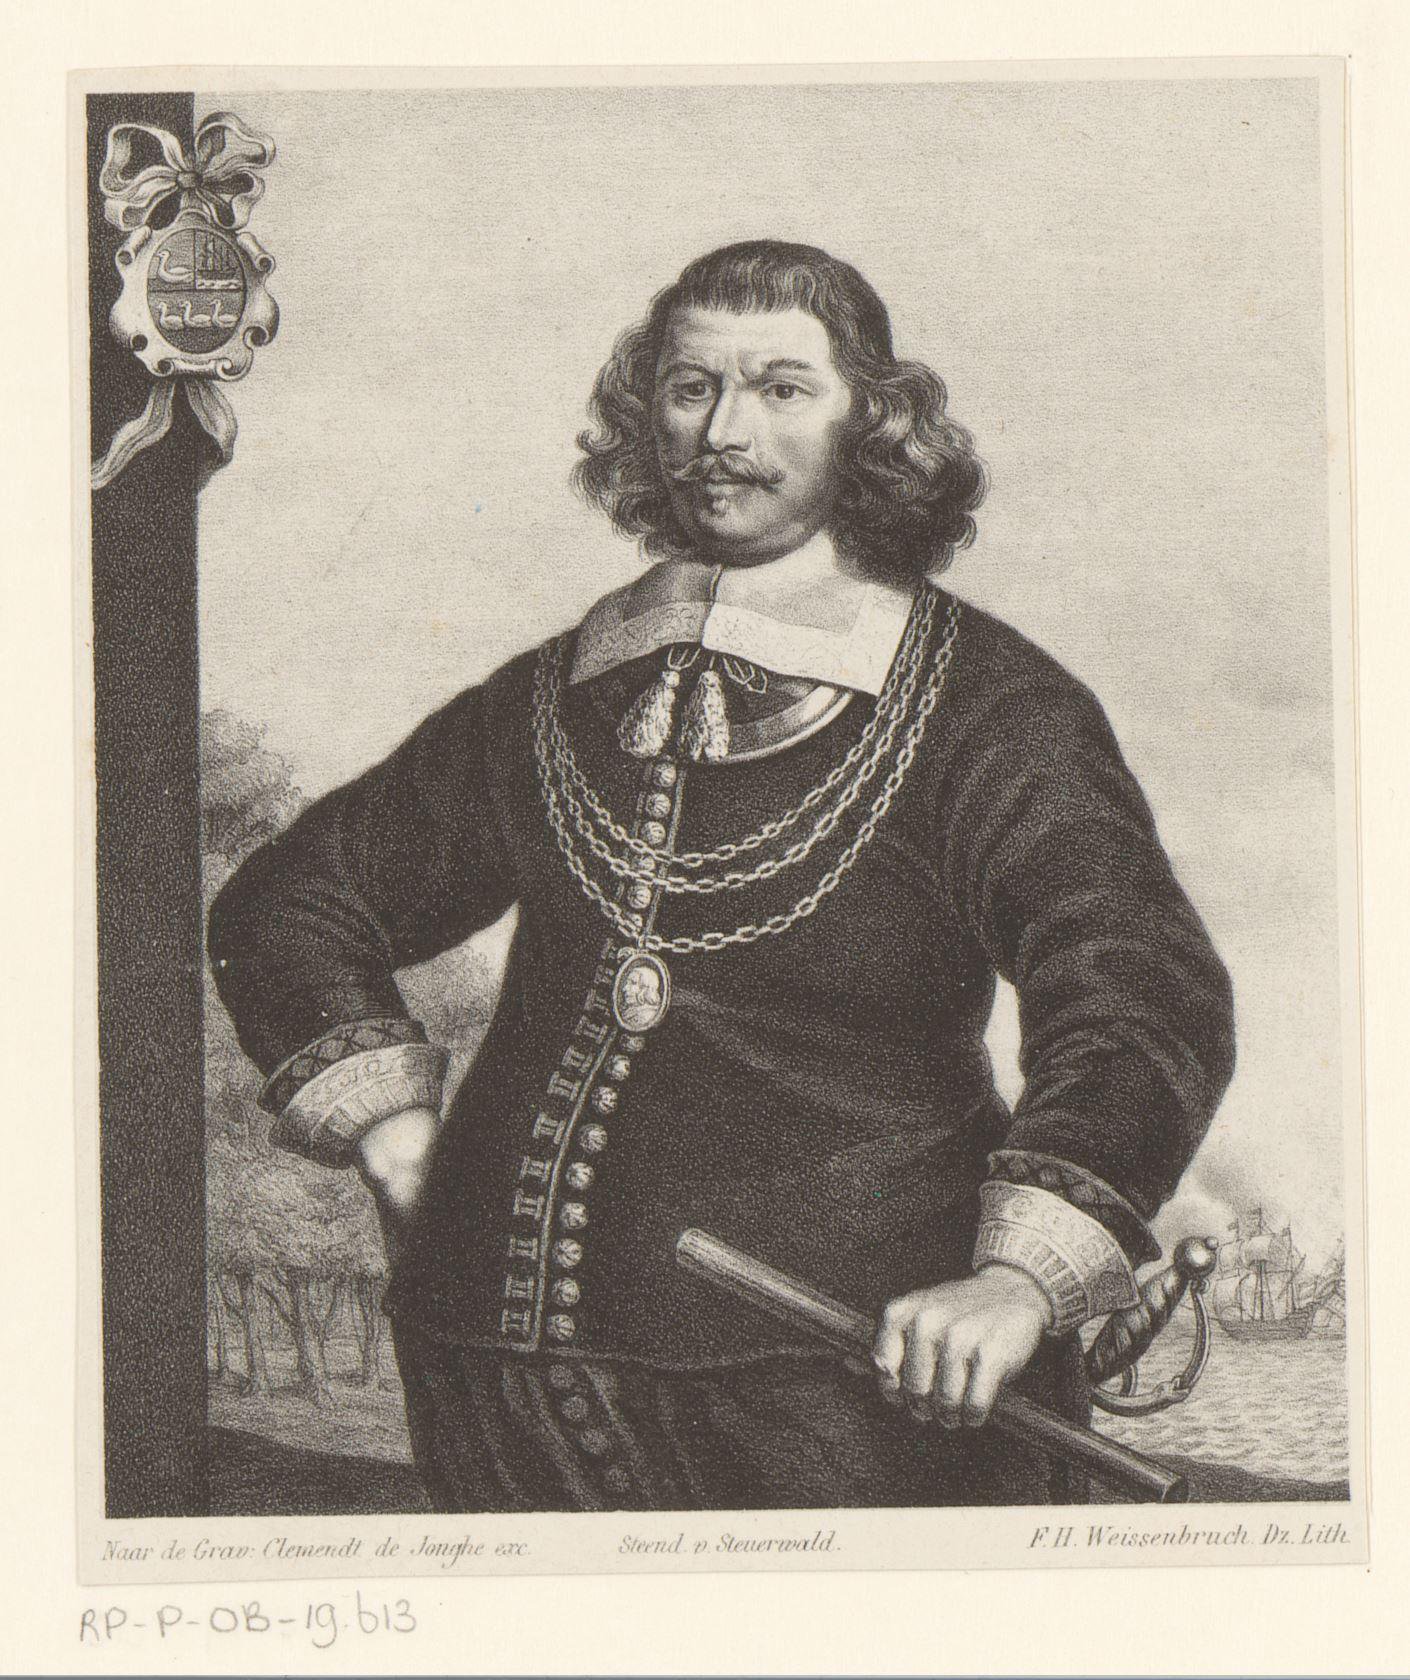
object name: print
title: Portret van Pieter Florisse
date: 1858-1862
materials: paper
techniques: lithograph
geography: the hague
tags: historical persons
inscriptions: collector's mark: Lugt 2228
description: Prent uit: Jonge, J.C. de. Geschiedenis van het Nederlandsche zeewezen. Haarlem: Jonge, J.K.J. de, 1858-62.